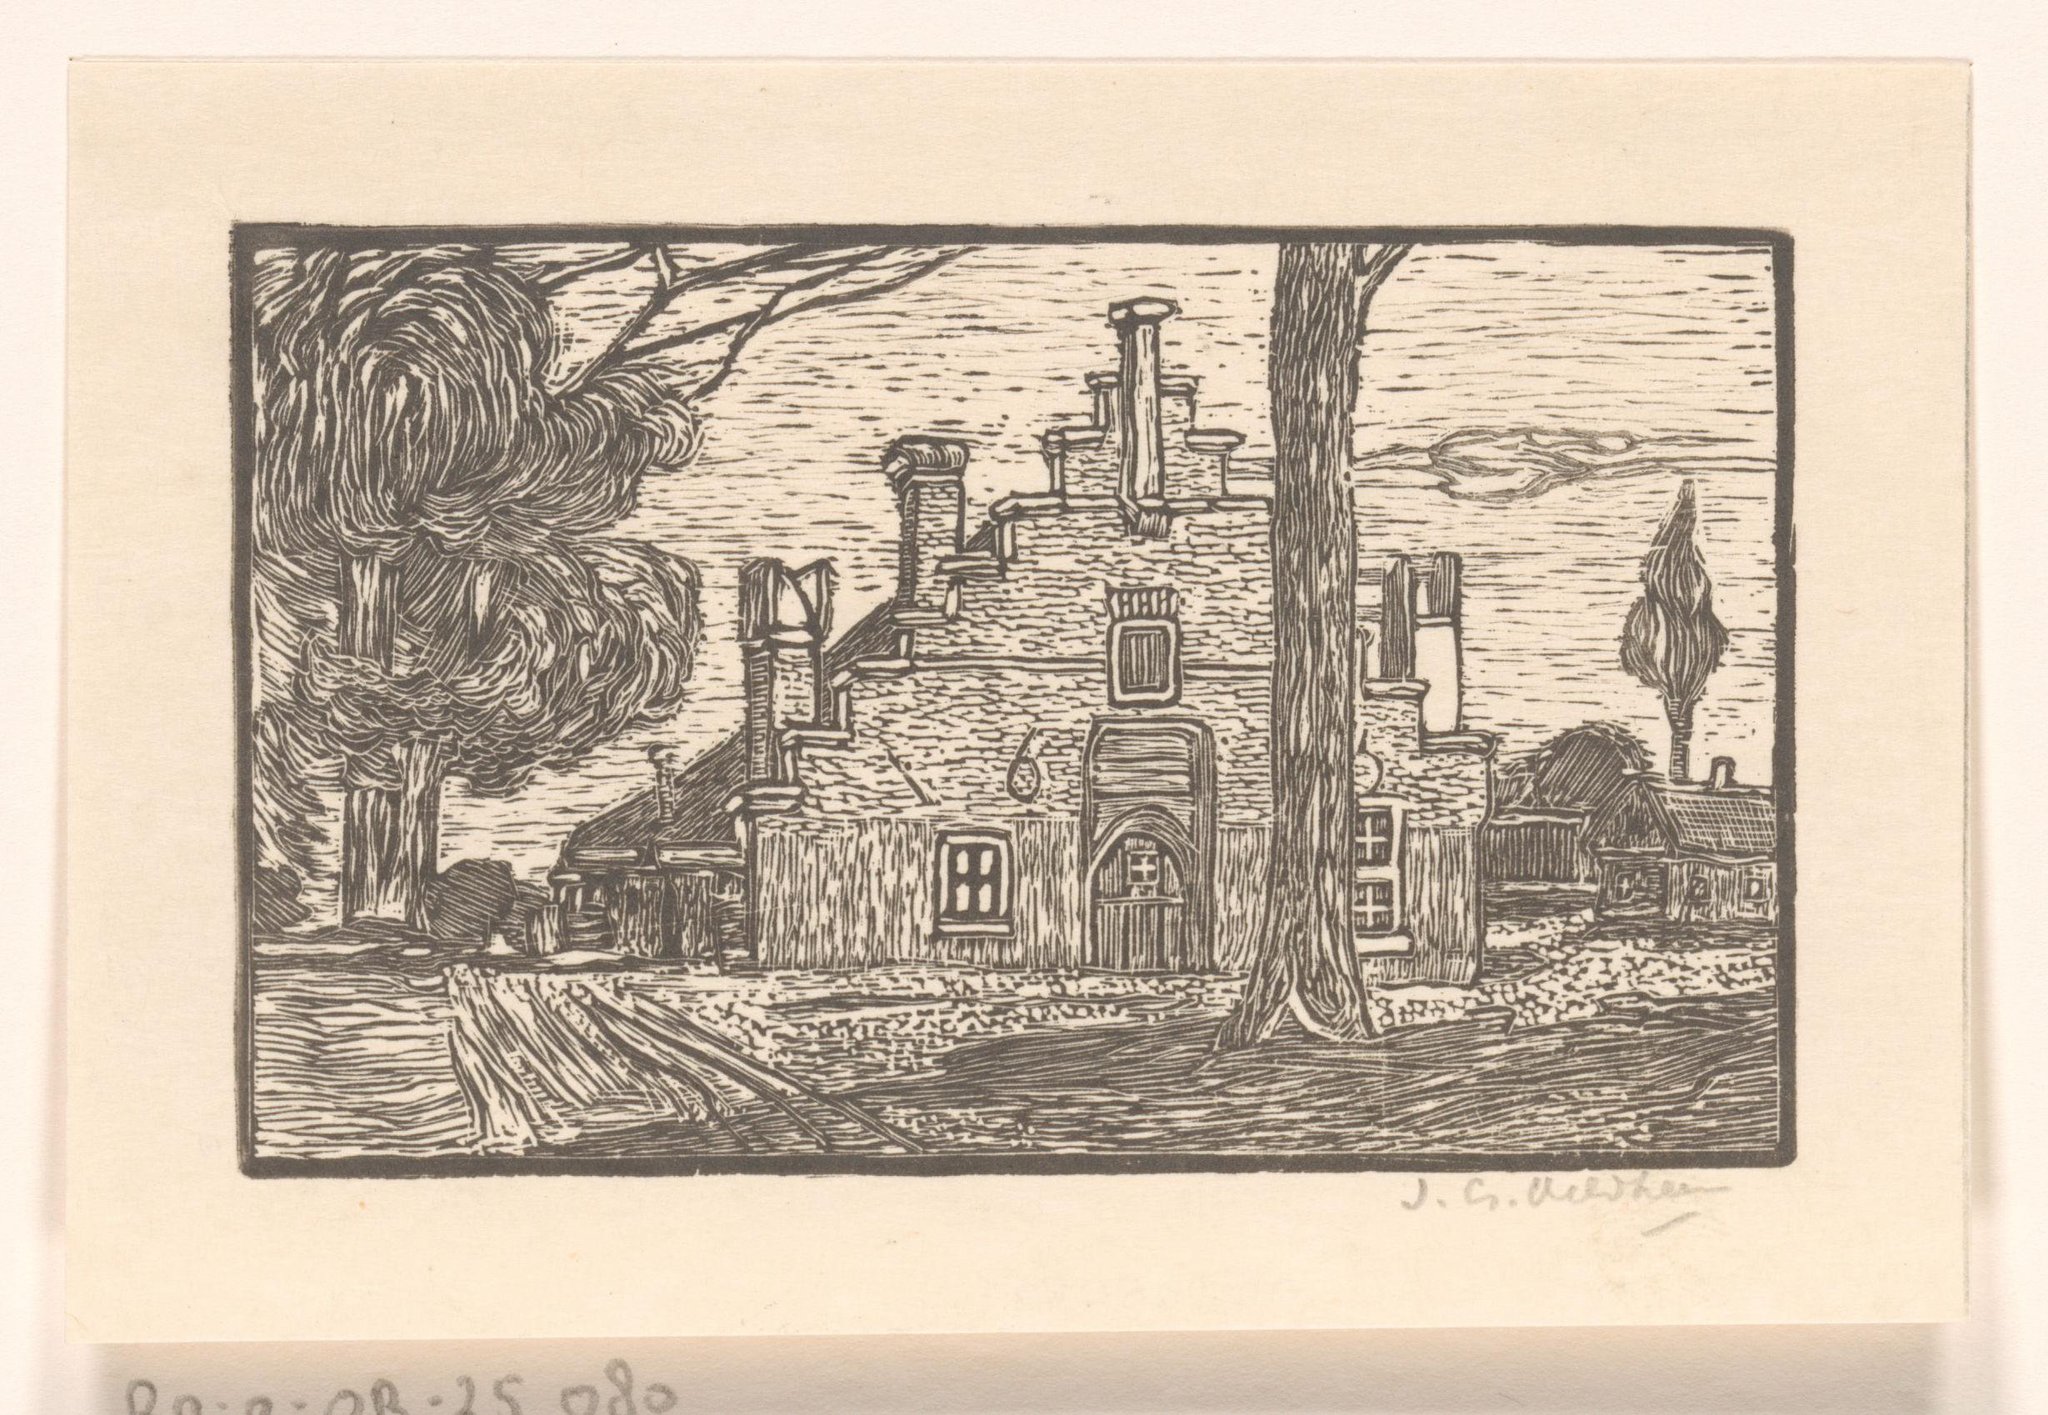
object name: print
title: Huis te Bergen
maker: jacobus gerardus veldheer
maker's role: draughtsman, print maker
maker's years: 1866-1954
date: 1876-1954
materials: paper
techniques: woodcut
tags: townhall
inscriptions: collector's mark: Lugt 2228